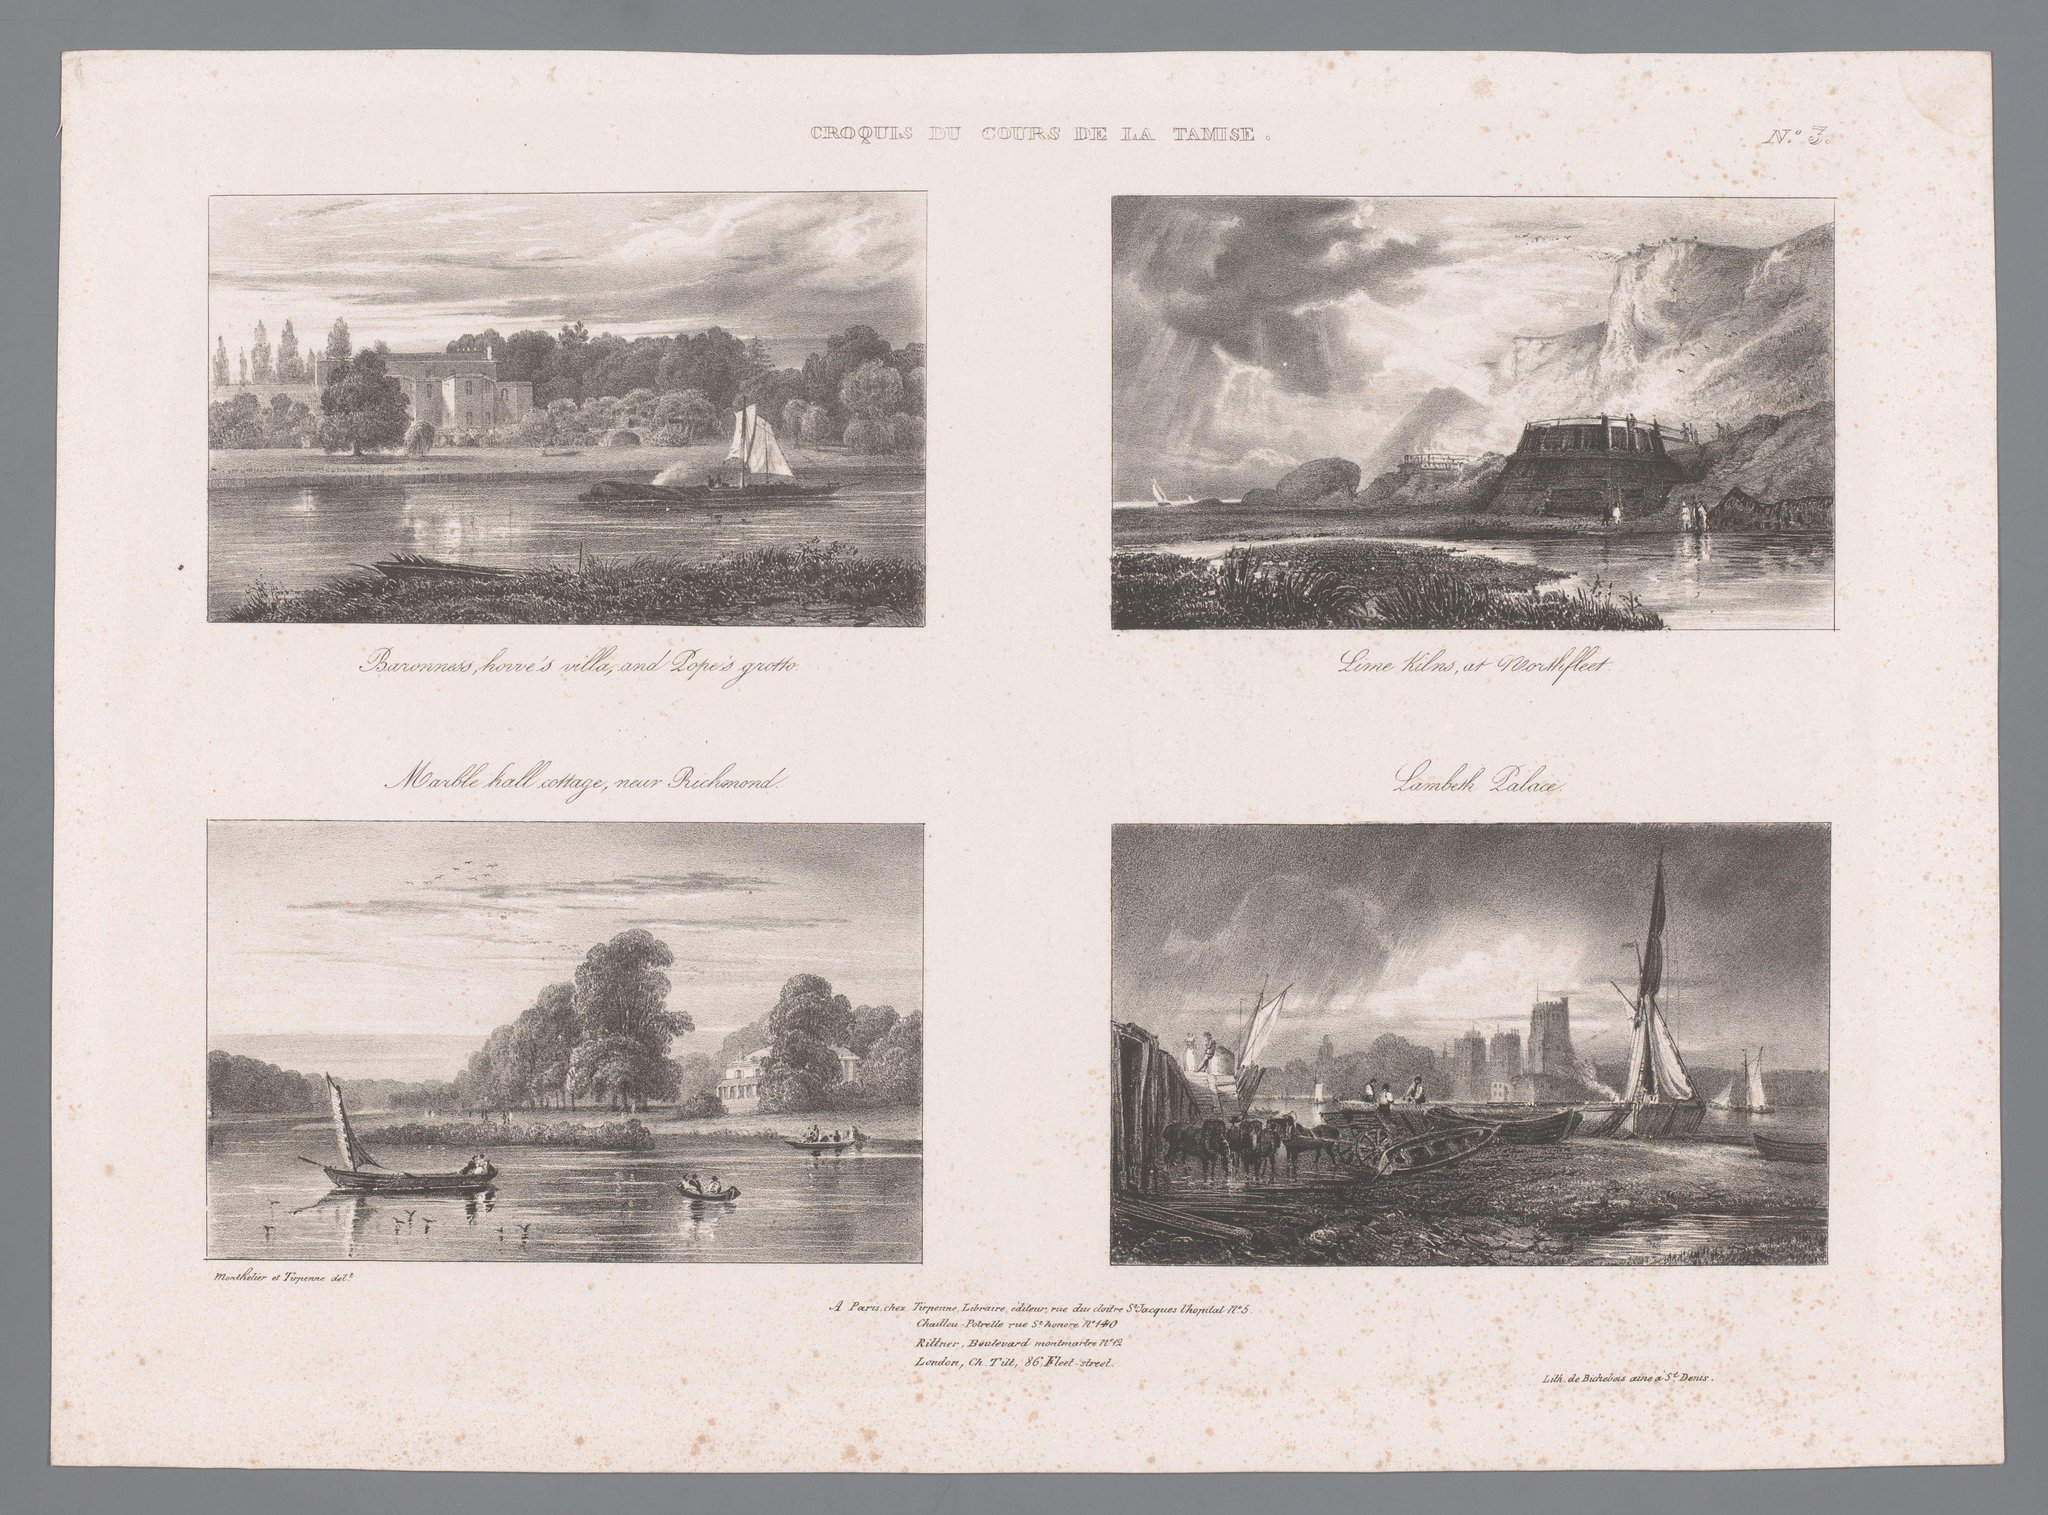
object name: print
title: Baronness, howe's villa, and Pope's grotto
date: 1829-1830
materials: paper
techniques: lithograph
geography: london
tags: castle, river, ships (in general) - cc - more than one ship, london, thames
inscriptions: collector's mark: Lugt 2228